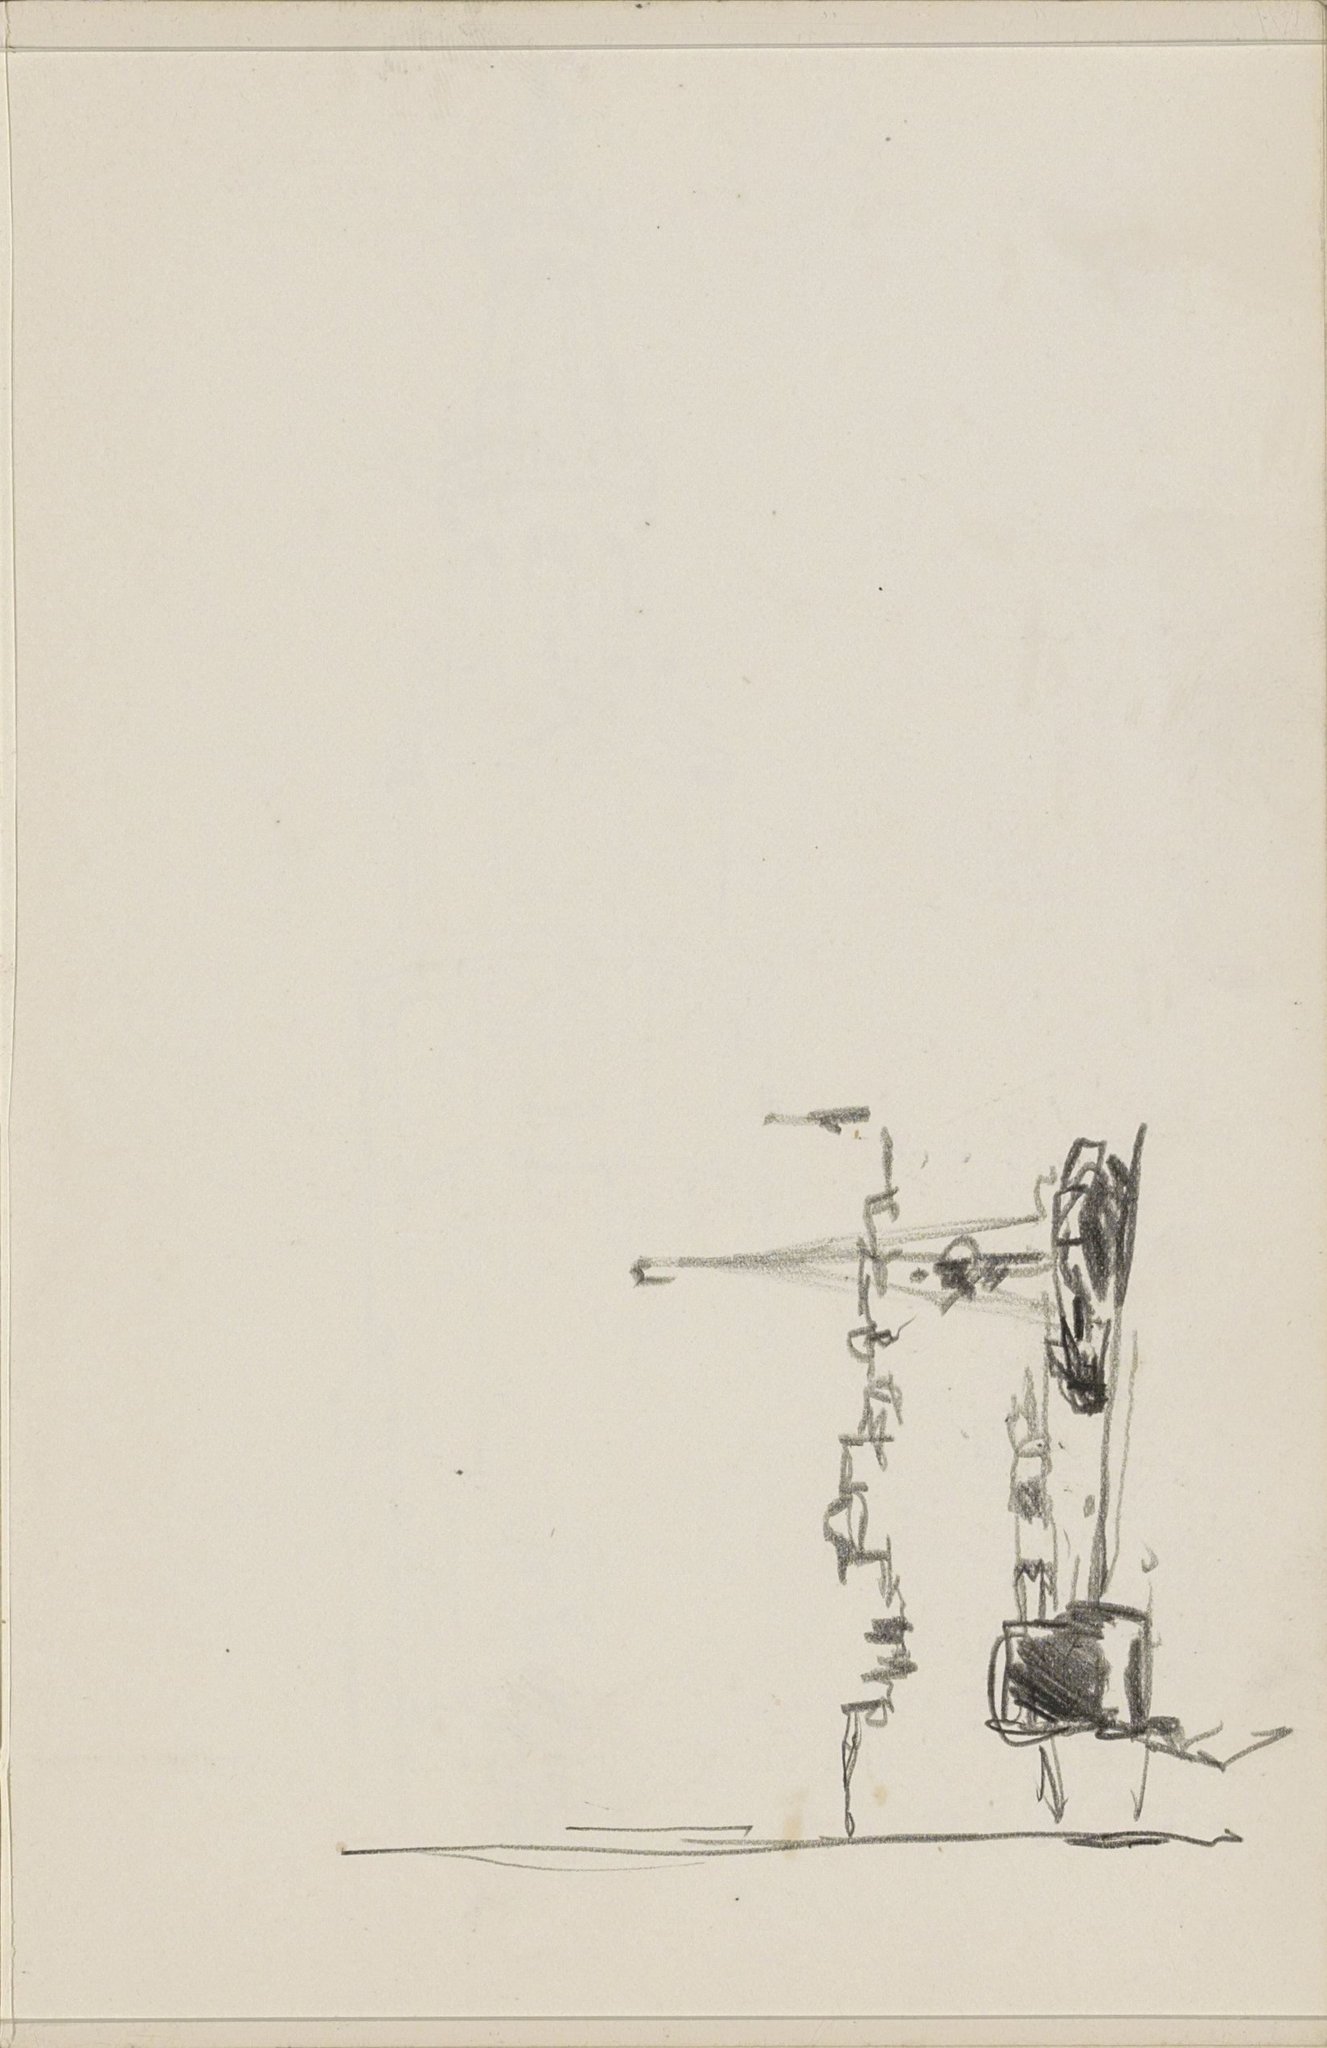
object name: sketchbook leaf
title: Aangemeerde zeilboot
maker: cornelis vreedenburgh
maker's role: draughtsman, print maker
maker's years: 1880-1946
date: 1890-1946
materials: chalk, paper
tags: sailing-ship, sailing-boat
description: Op de achtergrond het silhouet van een dorp of stad. Blad 25 recto uit een schetsboek met 41 bladen.